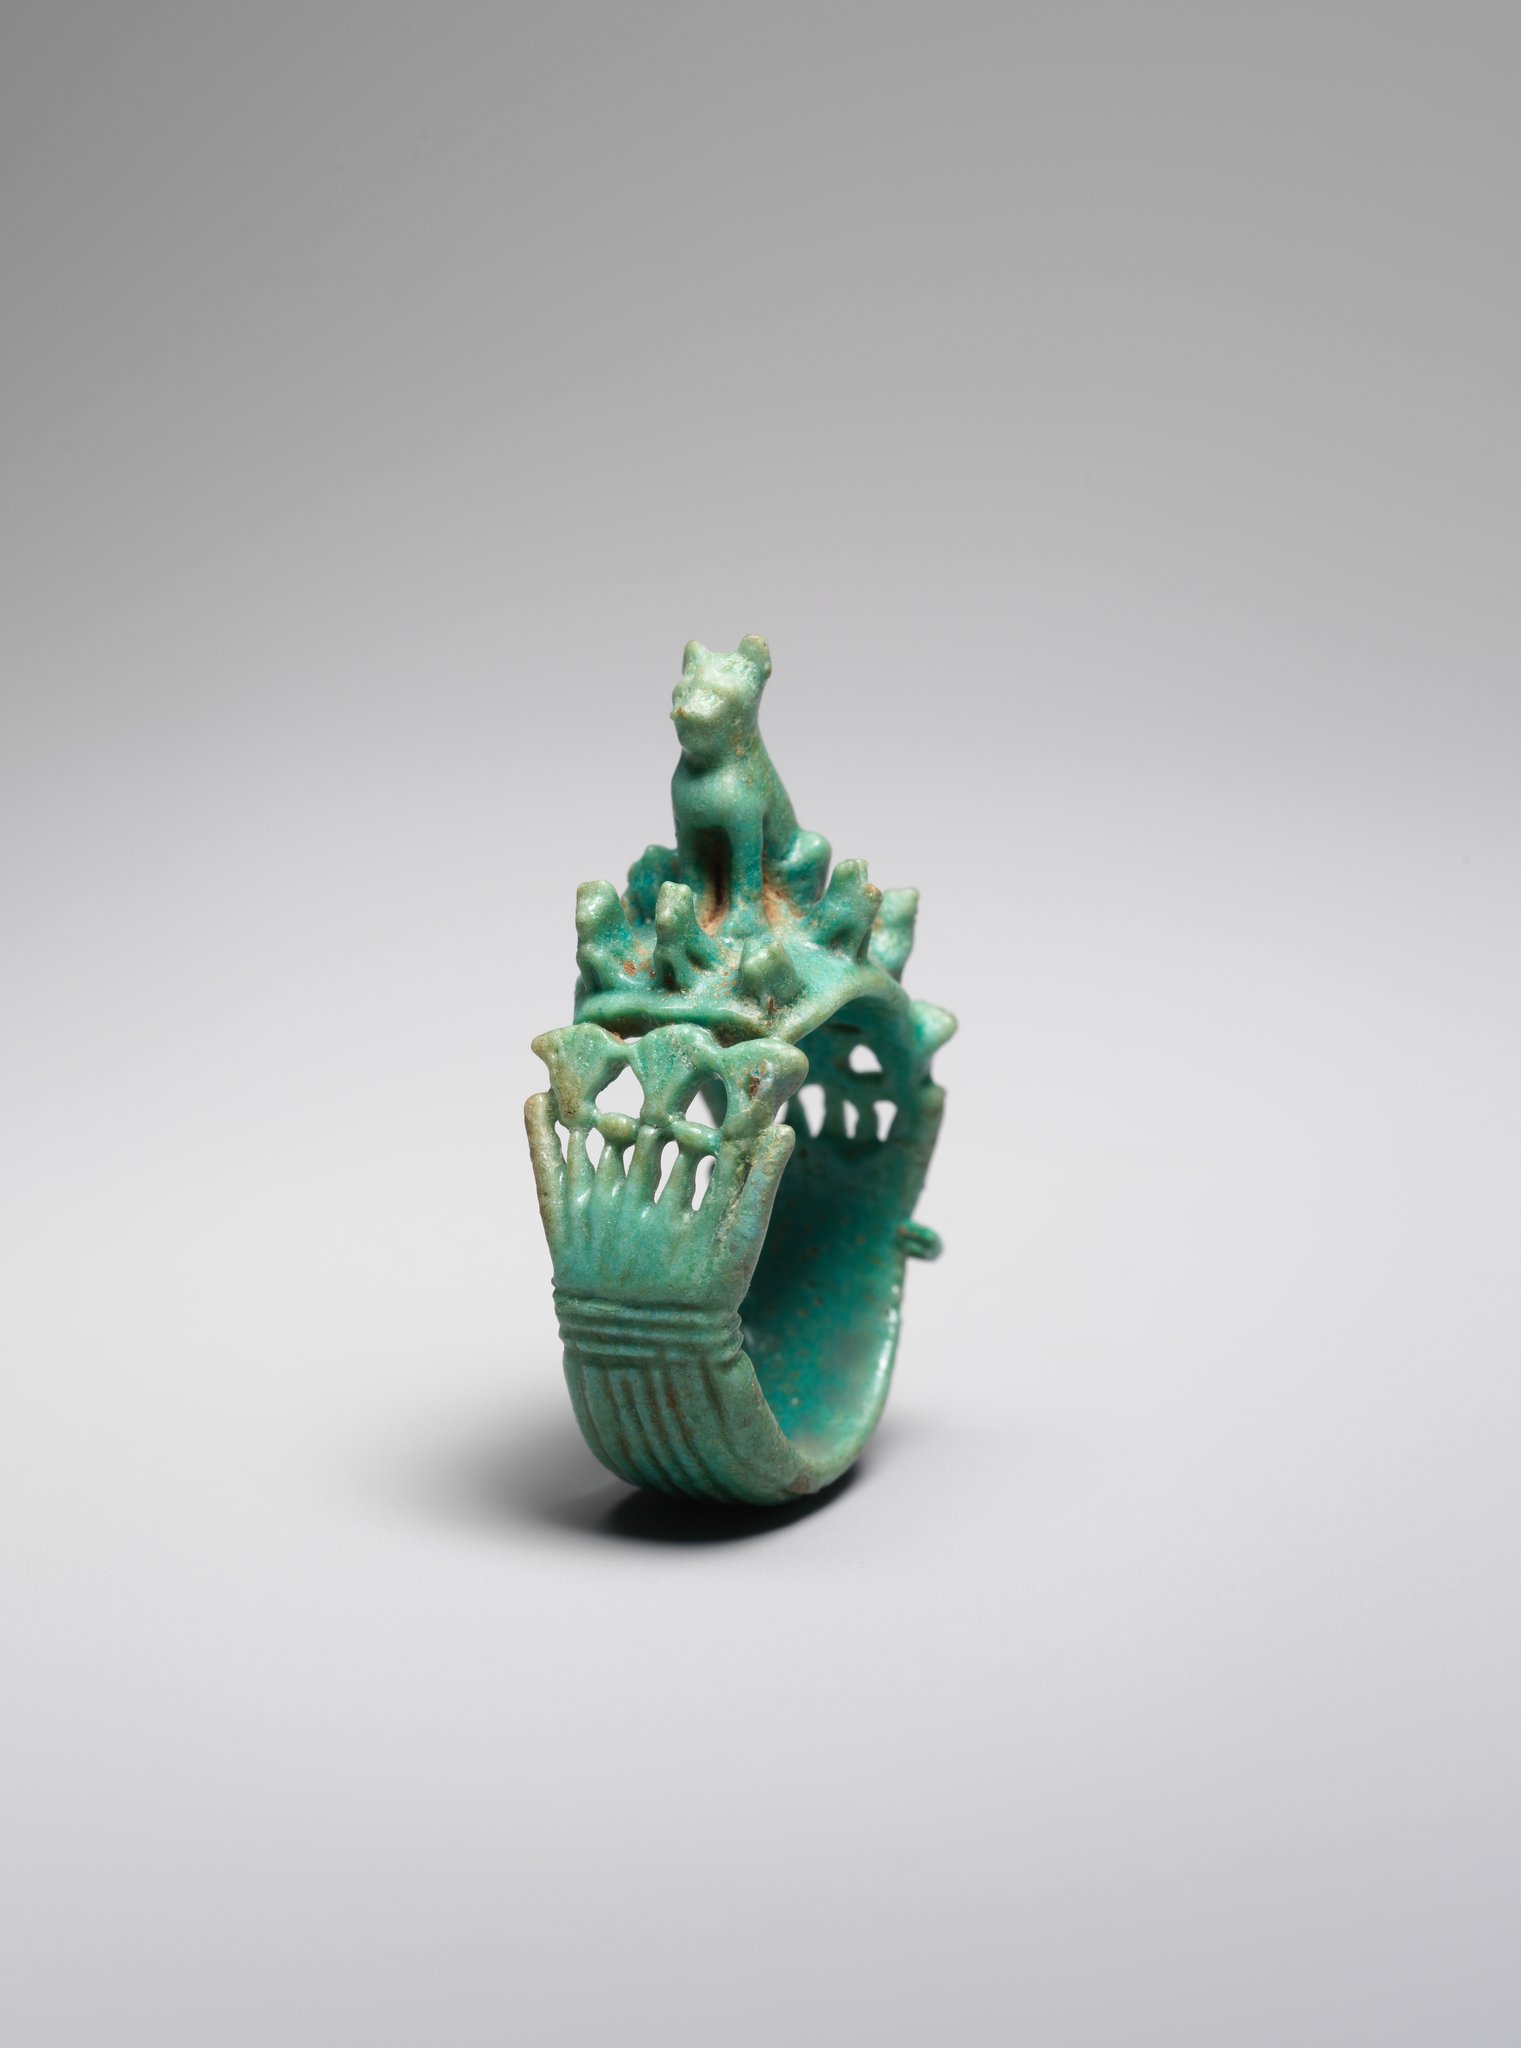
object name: ring, cat, kitten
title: Ring with Cat and Kittens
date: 1295-664 BCE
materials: faience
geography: egypt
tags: cats